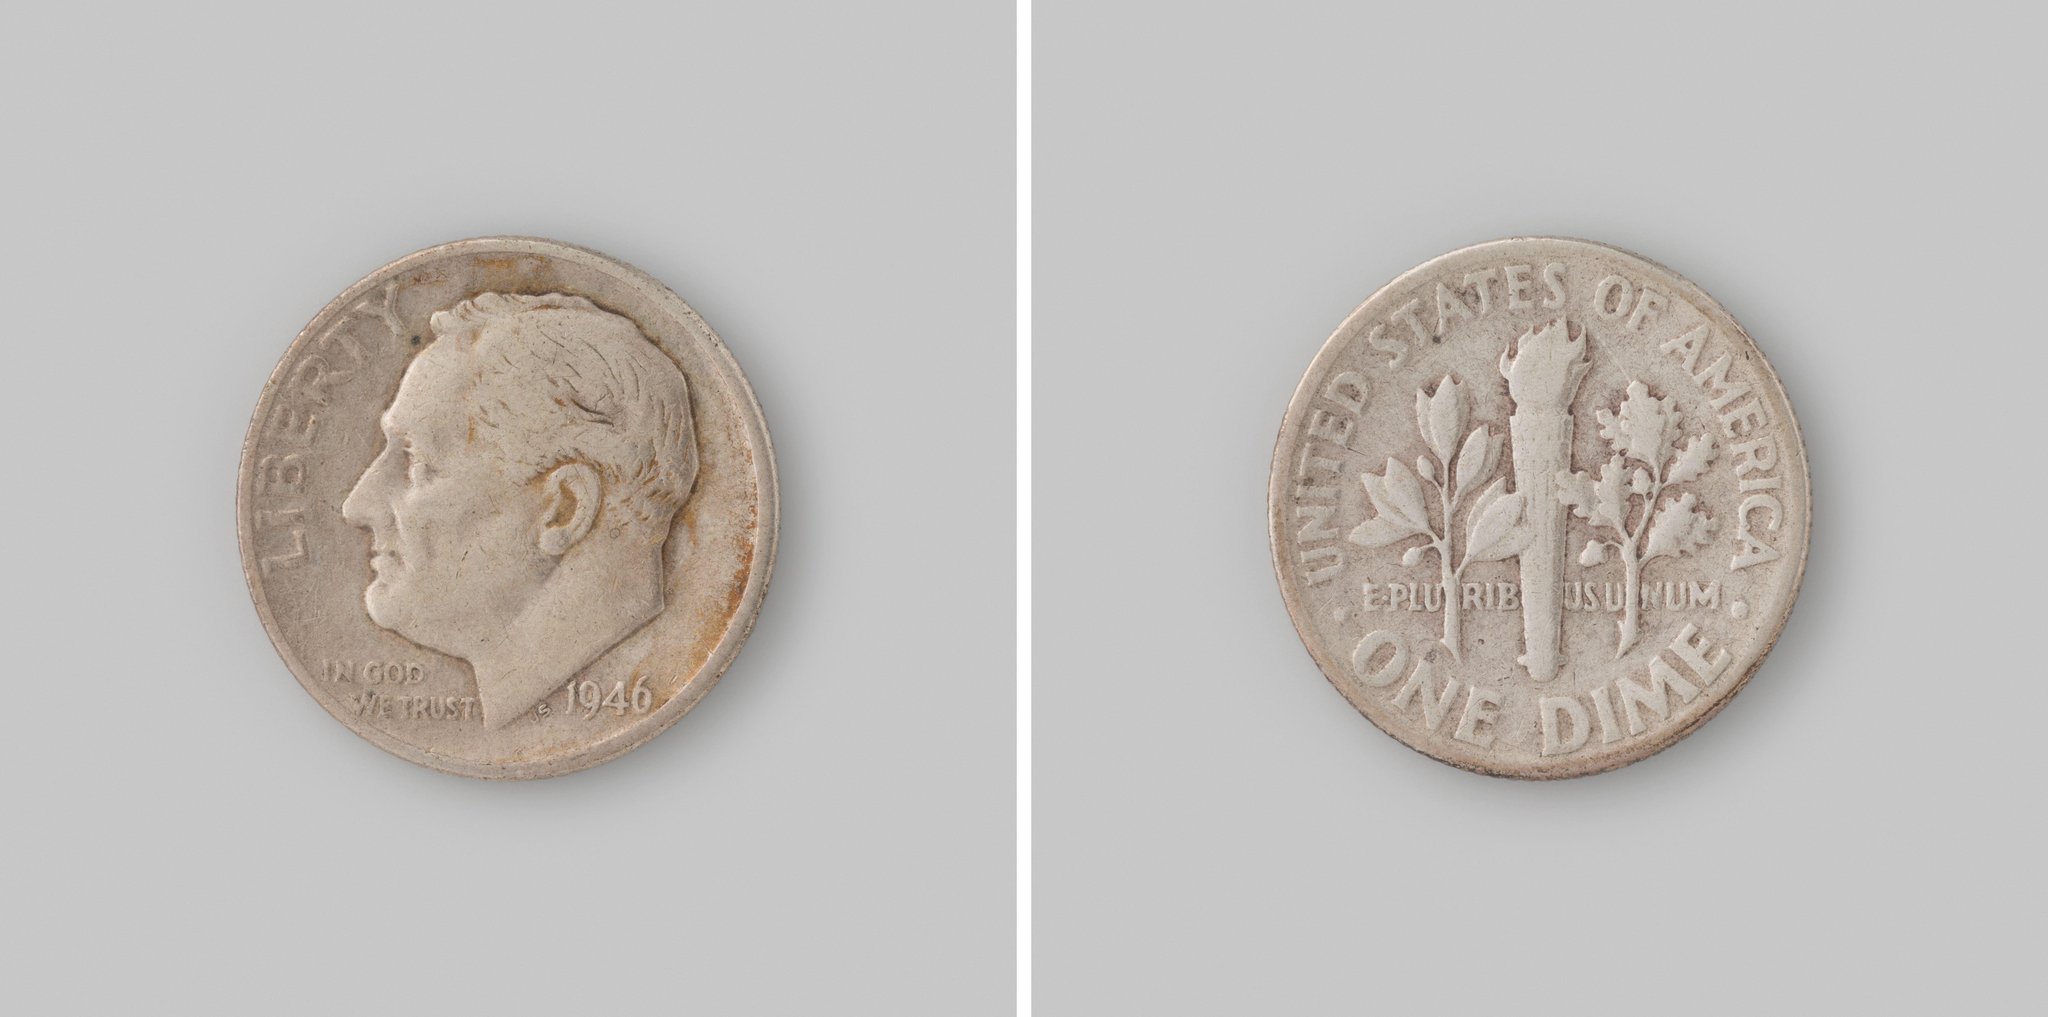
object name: coin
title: Verenigde Staten van Amerika, dime of 10 cents, 1946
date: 1946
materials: silver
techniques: striking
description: Zilveren munt. Voorzijde: hoofd van Roosevelt naar links, waaronder jaartal. Keerzijde: tussen twee takken staande brandende fakkel. Onderaan waarde-aanduiding: one dime. Kartelrand.